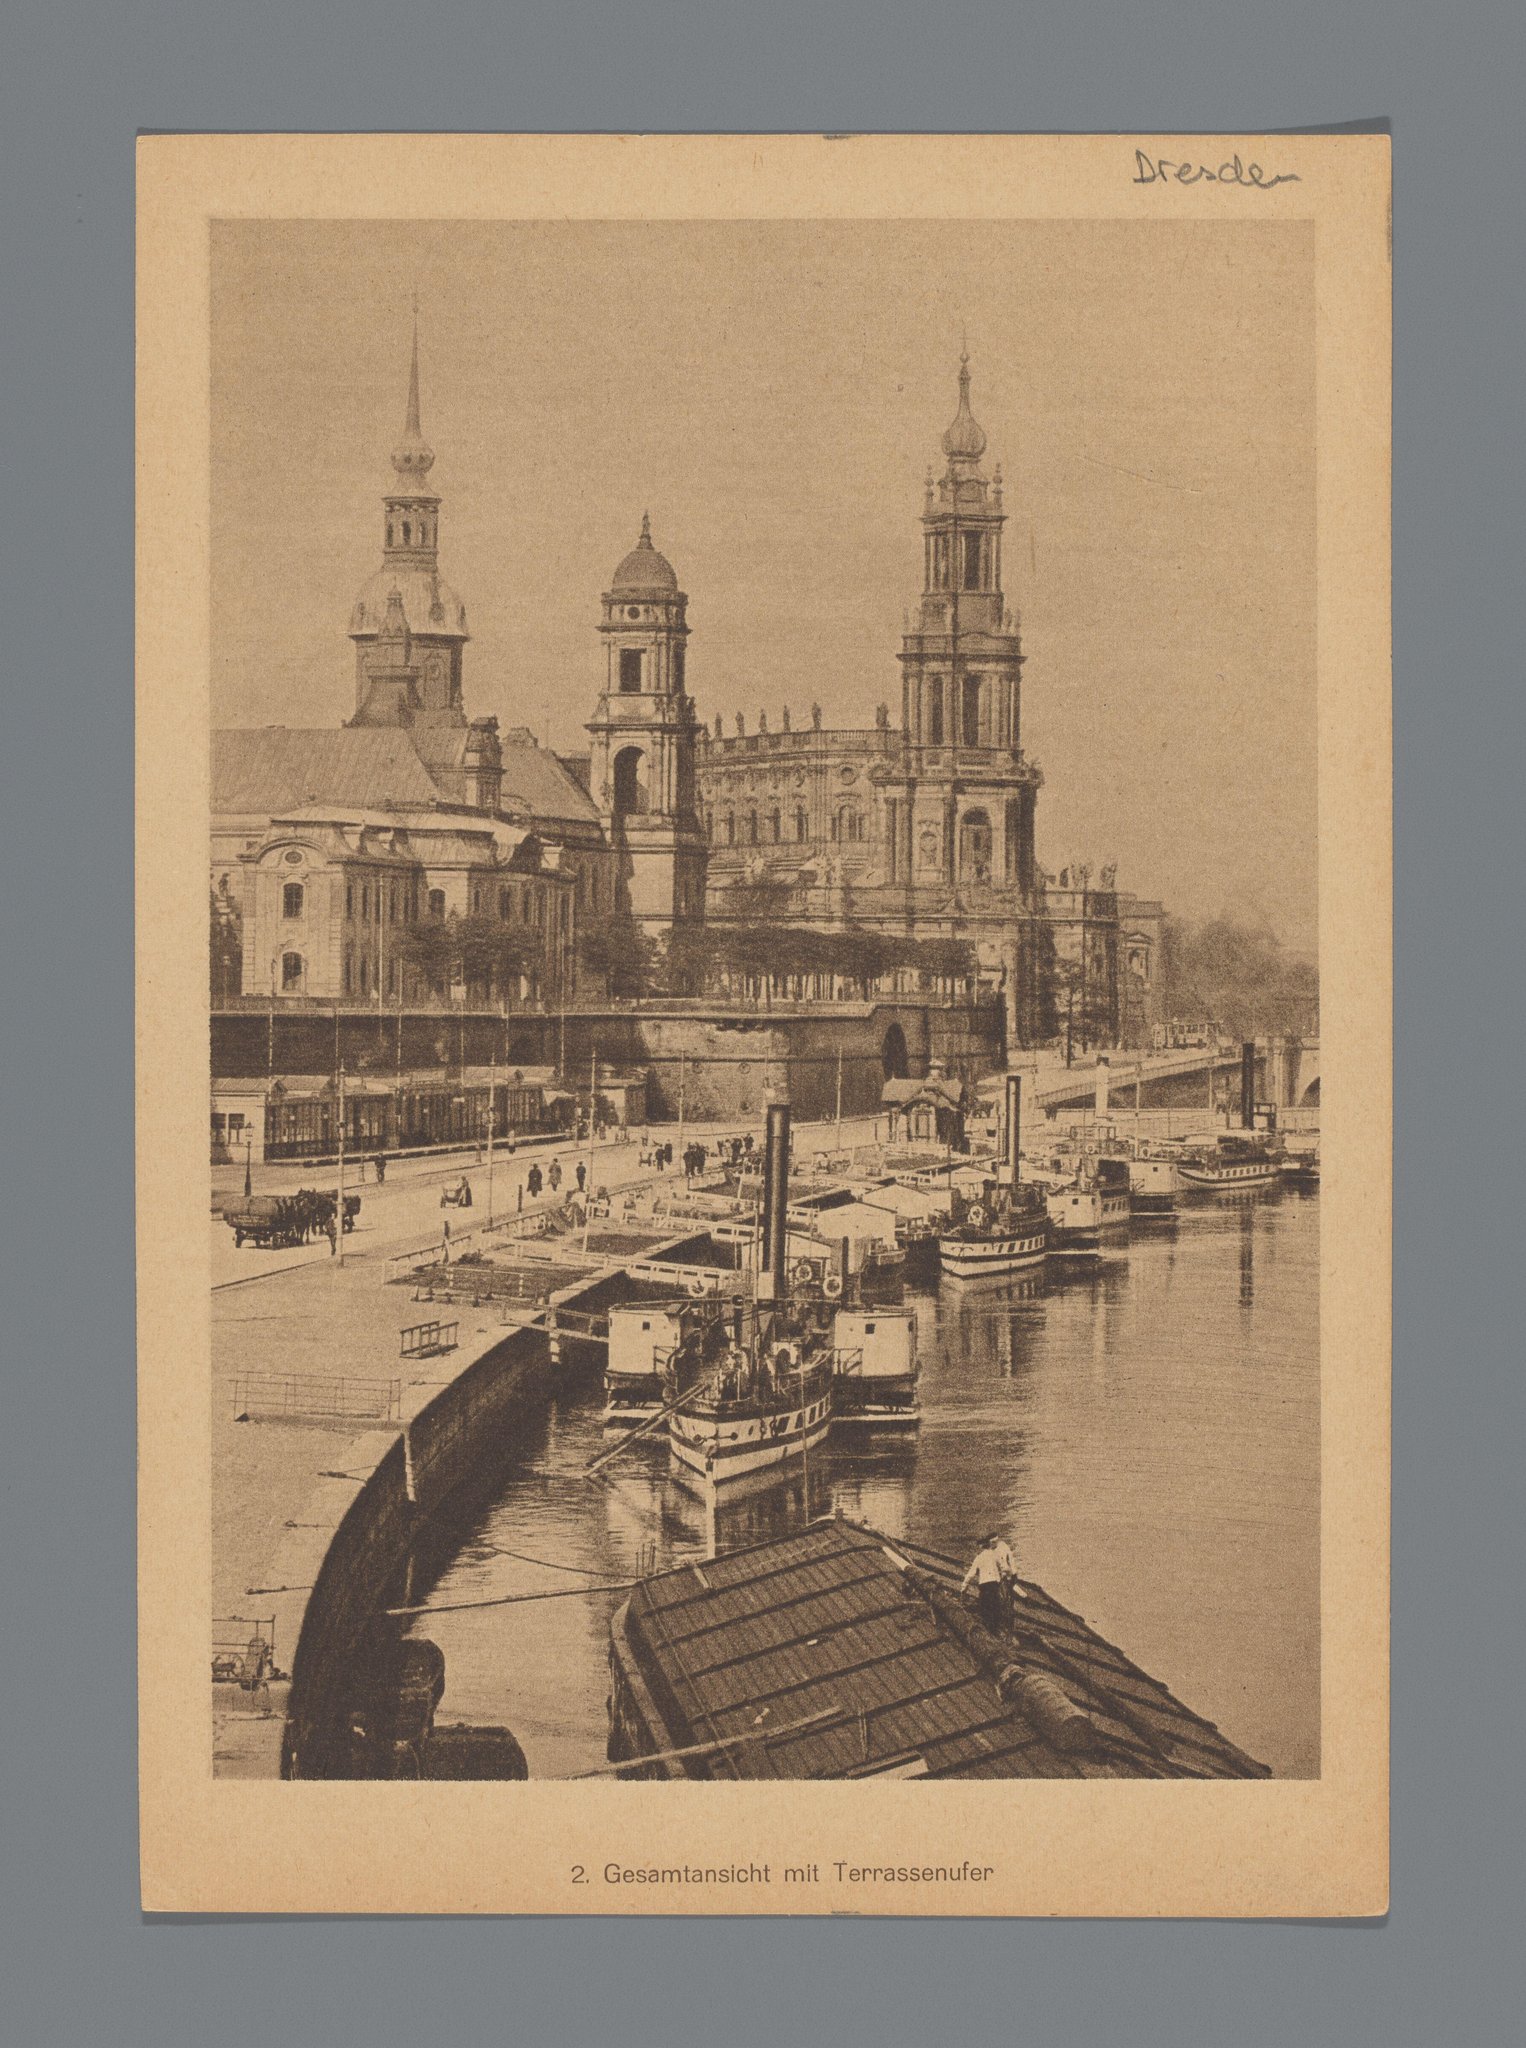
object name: photograph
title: Gesamtansicht mit Terrassenufer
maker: Anonymous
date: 1880-1920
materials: photographic support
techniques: rotogravure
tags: dresden